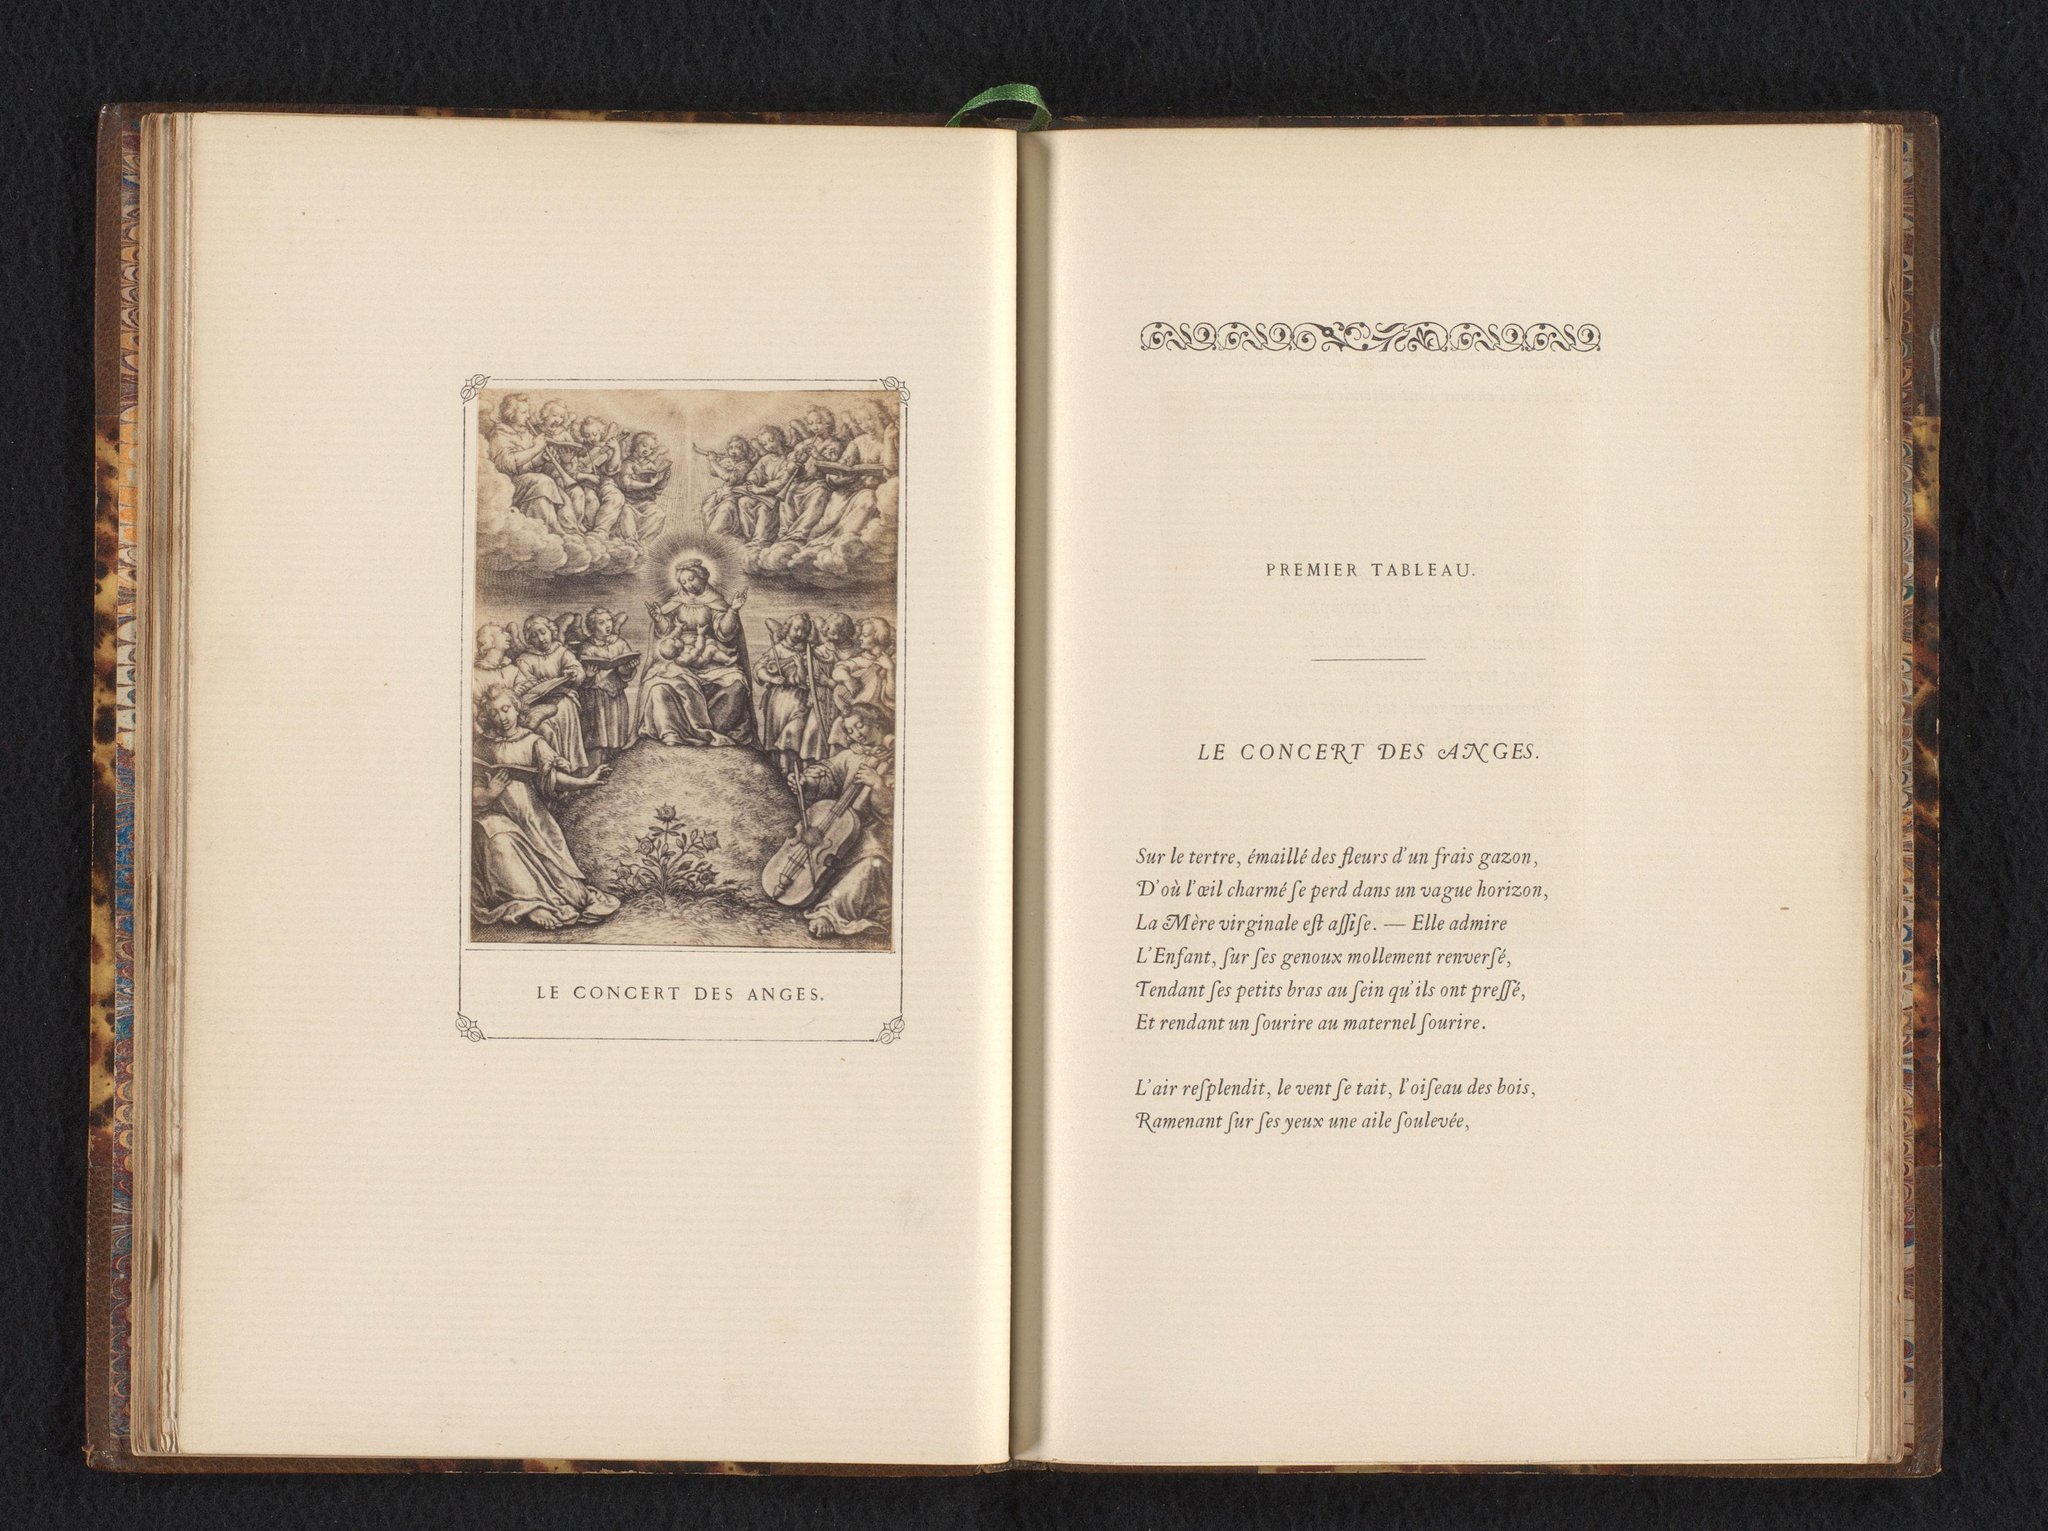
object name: photograph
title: Fotoreproductie van de gravure Le concert des anges door Hieronymus Wierix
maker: fierlants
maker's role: fotograaf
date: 1855-1860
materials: paper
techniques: albumen print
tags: angels singing, making music